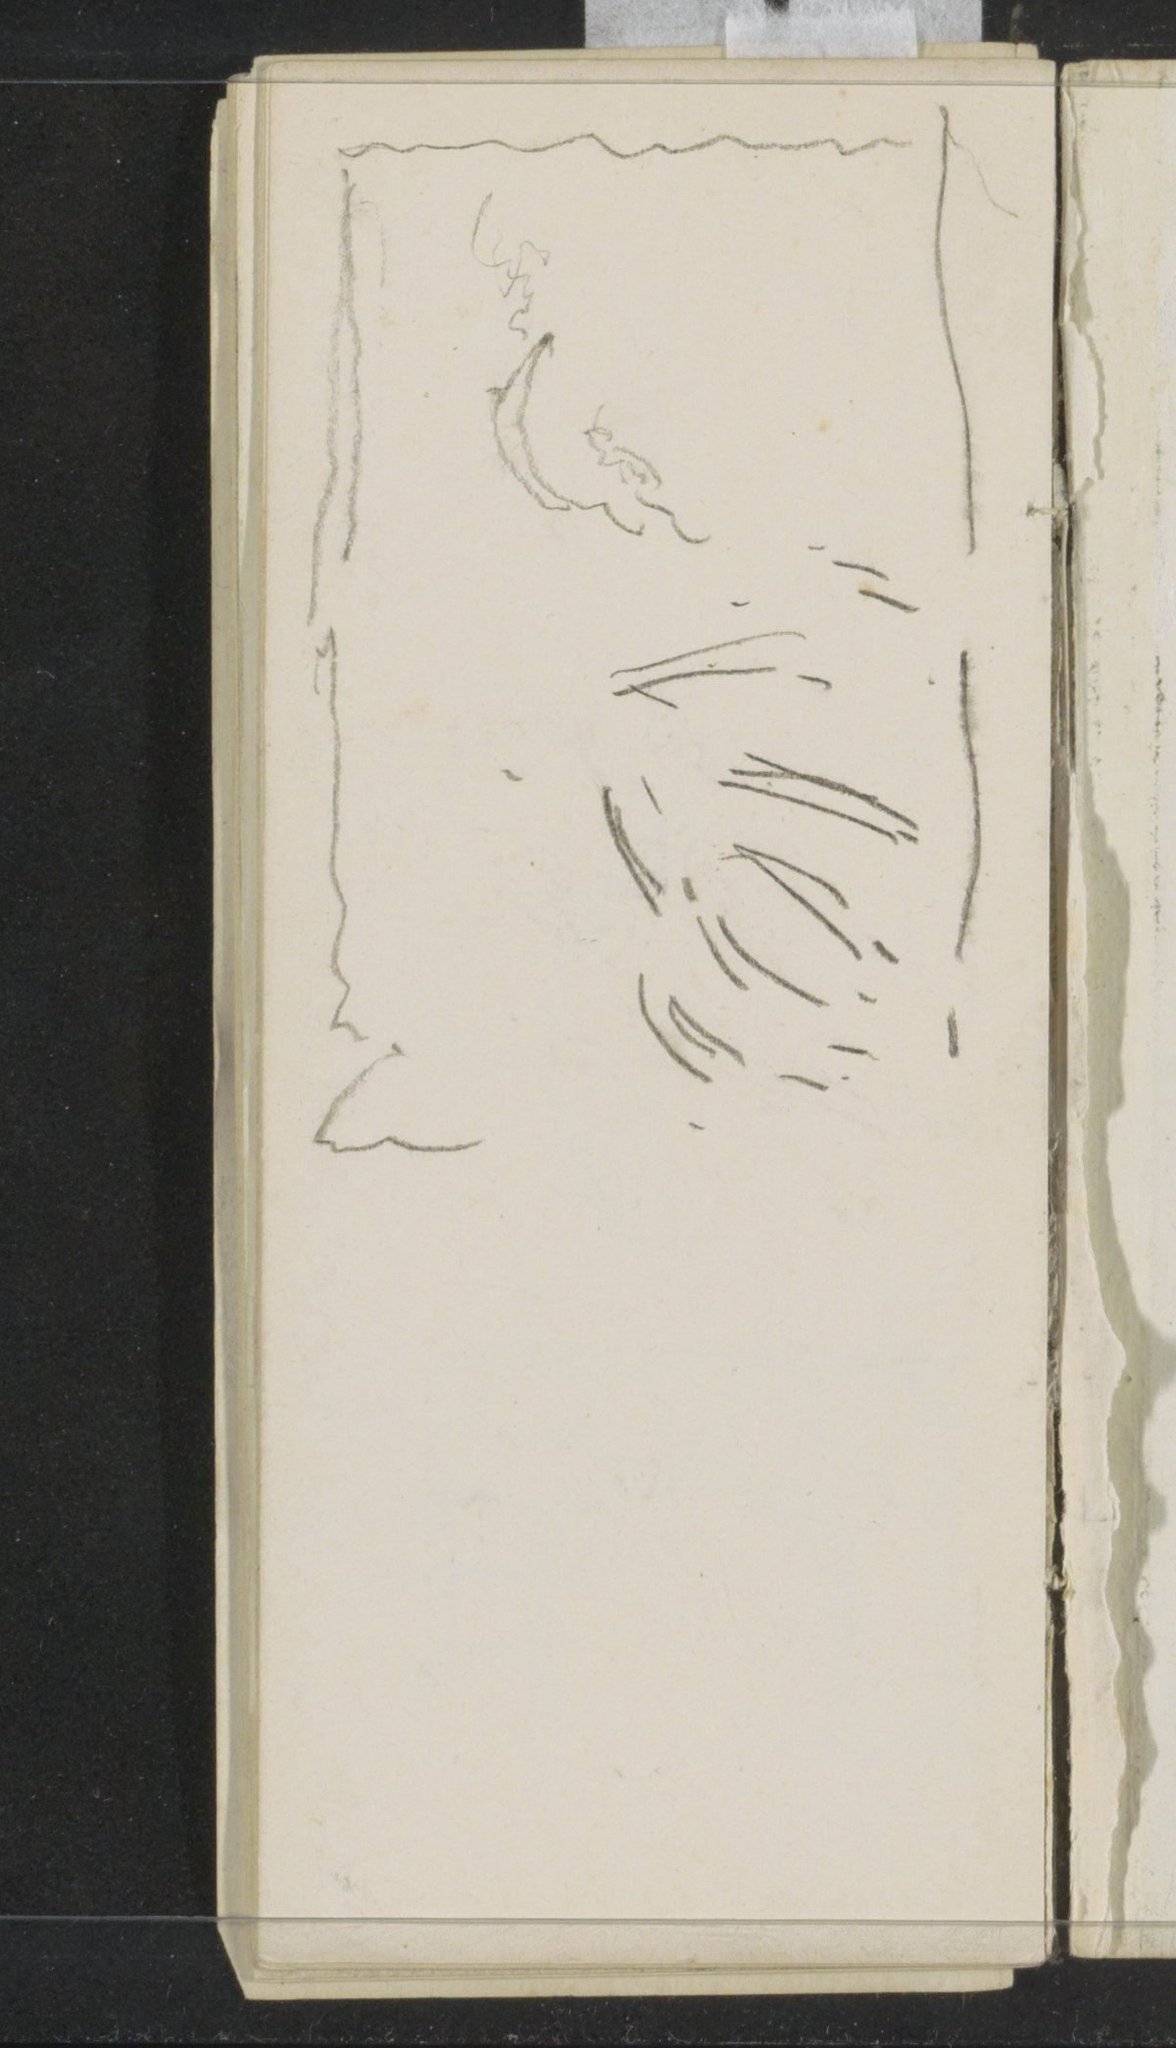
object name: sketchbook leaf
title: Studies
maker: gerrit willem dijsselhof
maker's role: designer, draughtsman, print maker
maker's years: 1866-1924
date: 1876-1924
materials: chalk, paper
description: Blad 24 verso uit een schetsboek met 24 bladen.